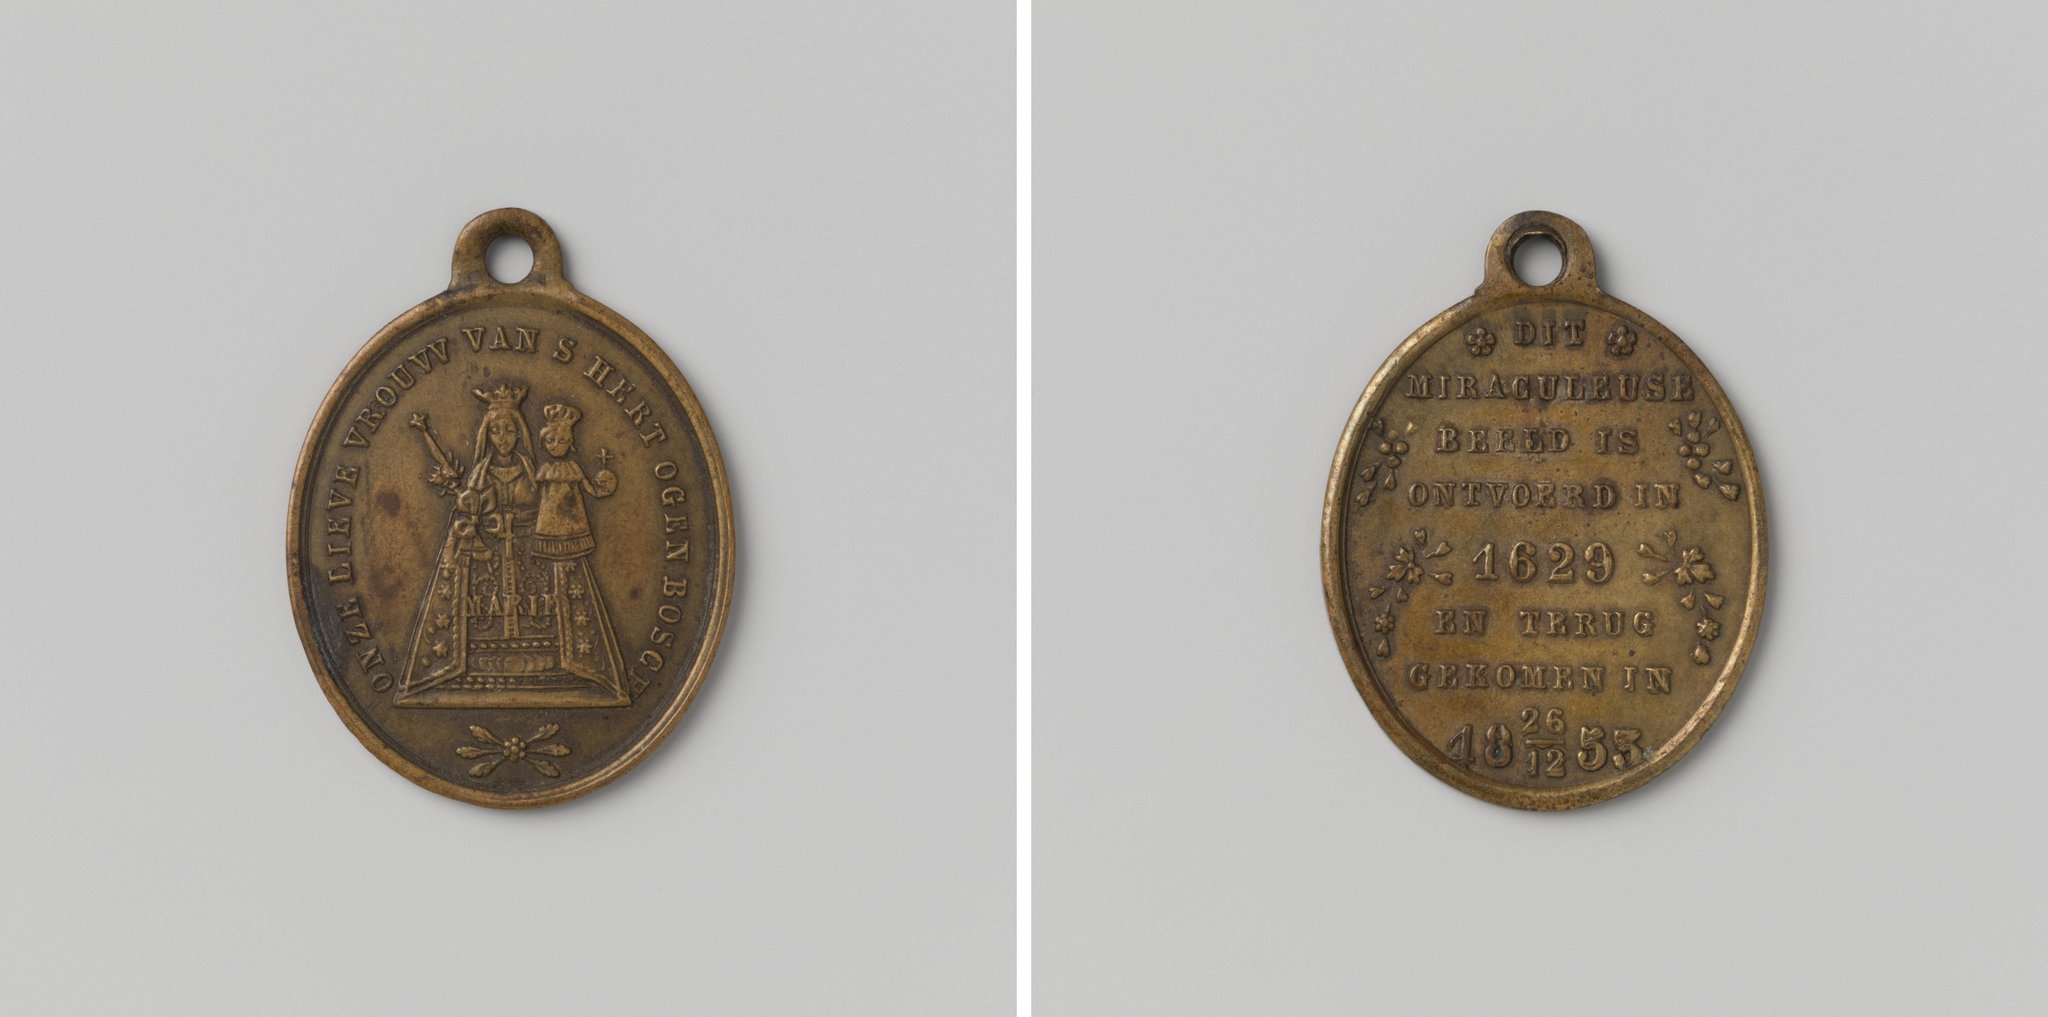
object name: devotional medal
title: Onze Lieve Vrouwe van 's-Hertogenbosch, mirakuleuze terugkeer van het ruim 200 jaar eerder ontvoerde Maria-beeld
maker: Anonymous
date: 1853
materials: brass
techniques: striking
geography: den bosch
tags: den bosch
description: Messing ovale penning aan draagoog. Voorzijde: gekroonde Maria met scepter in rechterhand en Christuskind op linkerarm binnen omschrift. Keerzijde: opschrift tussen versieringen van bloemen en vruchten